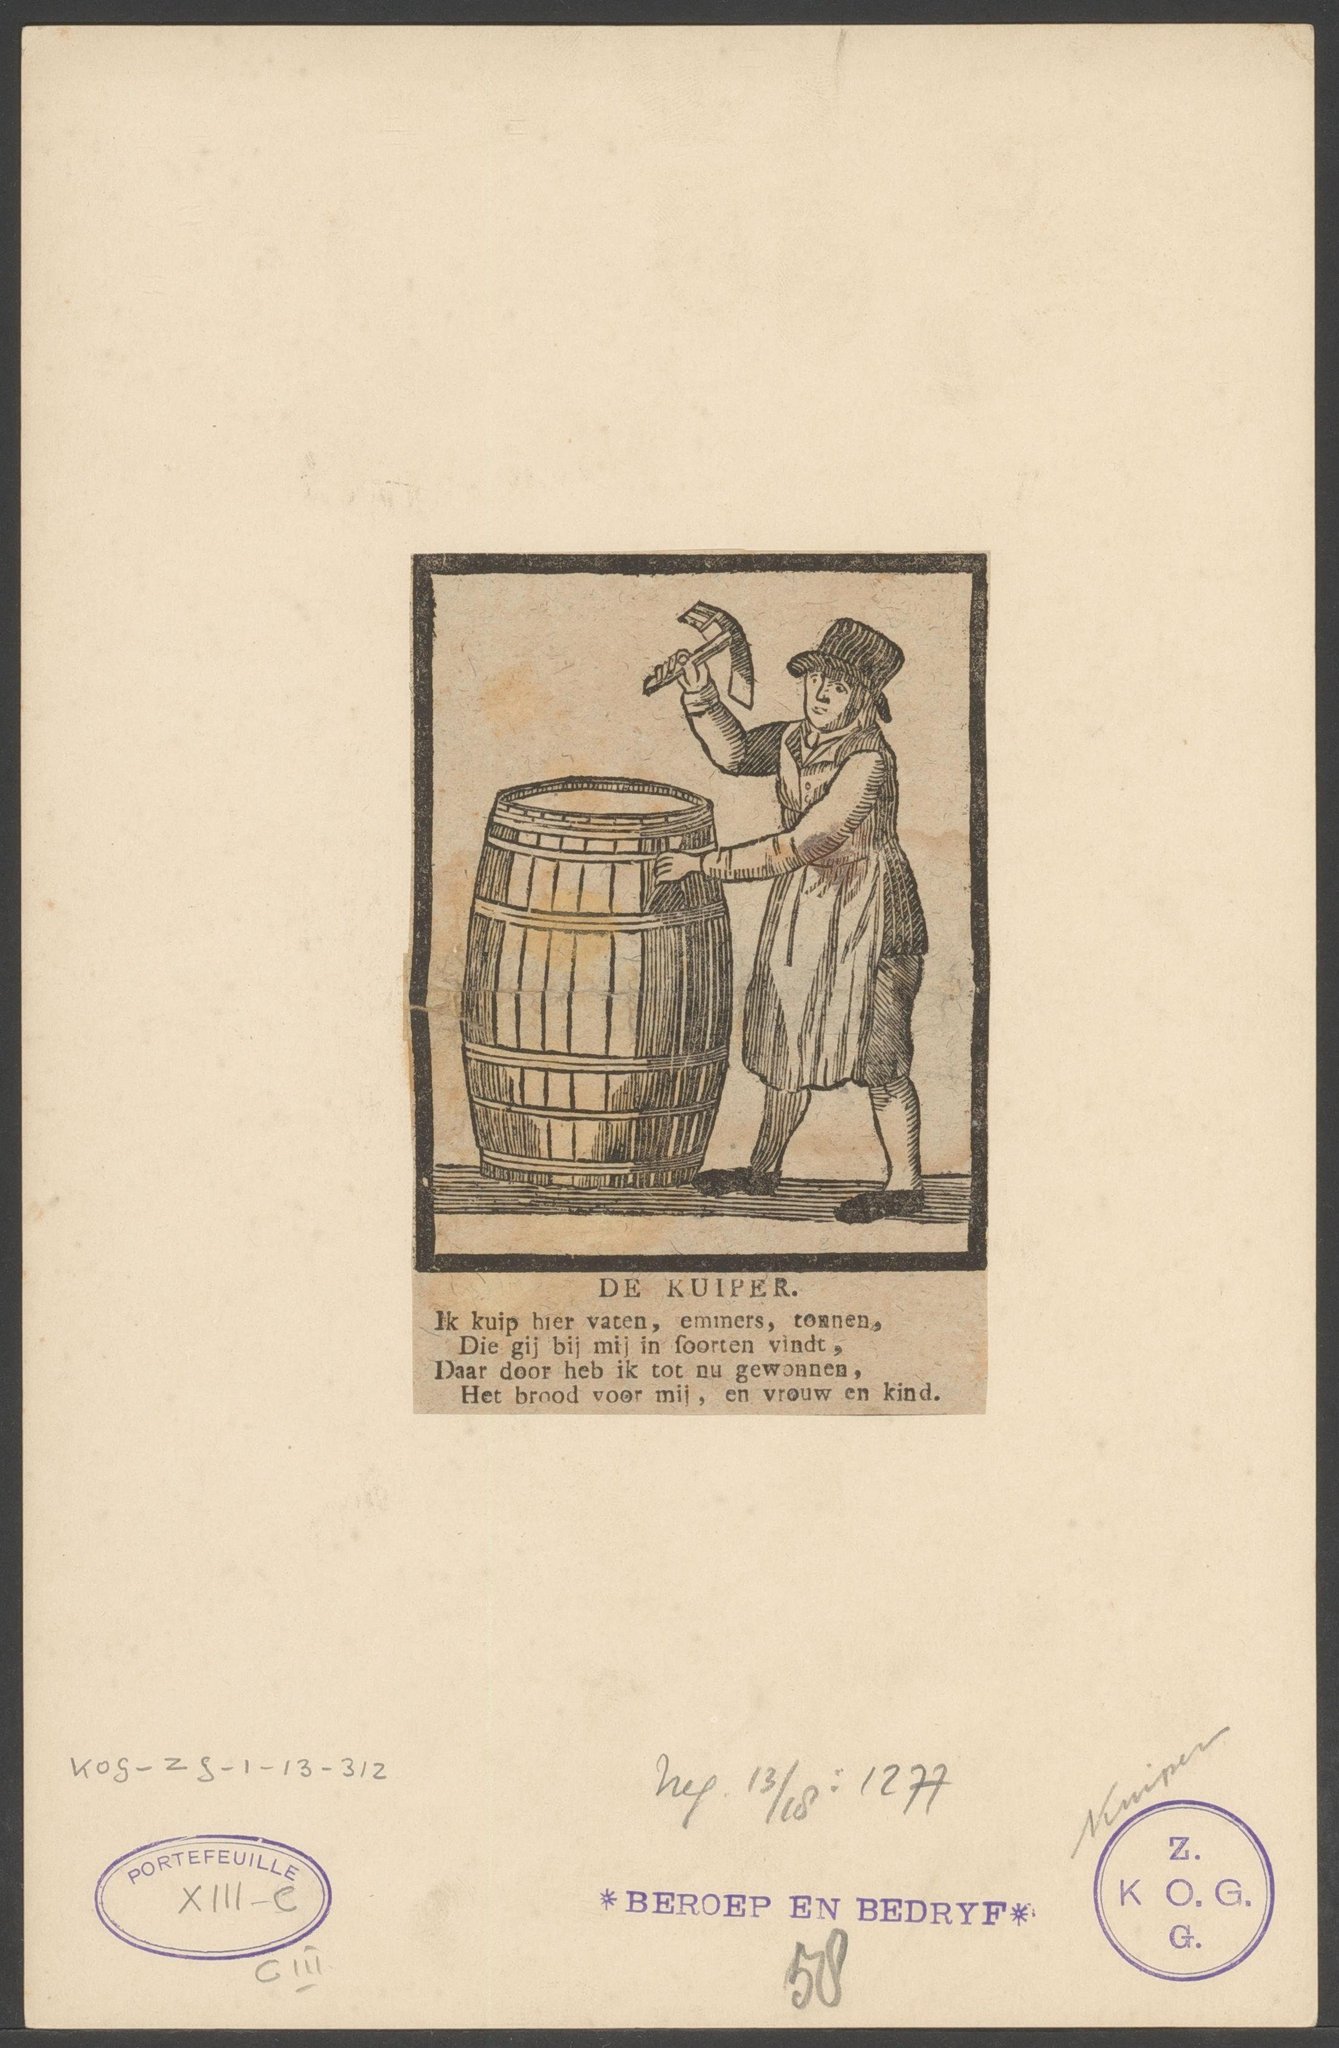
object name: print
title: Kuiper aan het werk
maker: Anonymous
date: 1800-1899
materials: paper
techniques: letterpress printing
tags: commercial fishery, seafood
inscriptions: stamp, collector's mark: Lugt 1641, stamp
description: De kuiper aan het werk. Onderaan een vierregelig vers. Onderwerpsrubrieken binnen de Atlas Zeden en Gewoonten: Handel, Nijverheid en verkeer, Beroep en bedrijf, Mannelijk, Bewerkers van het hout.